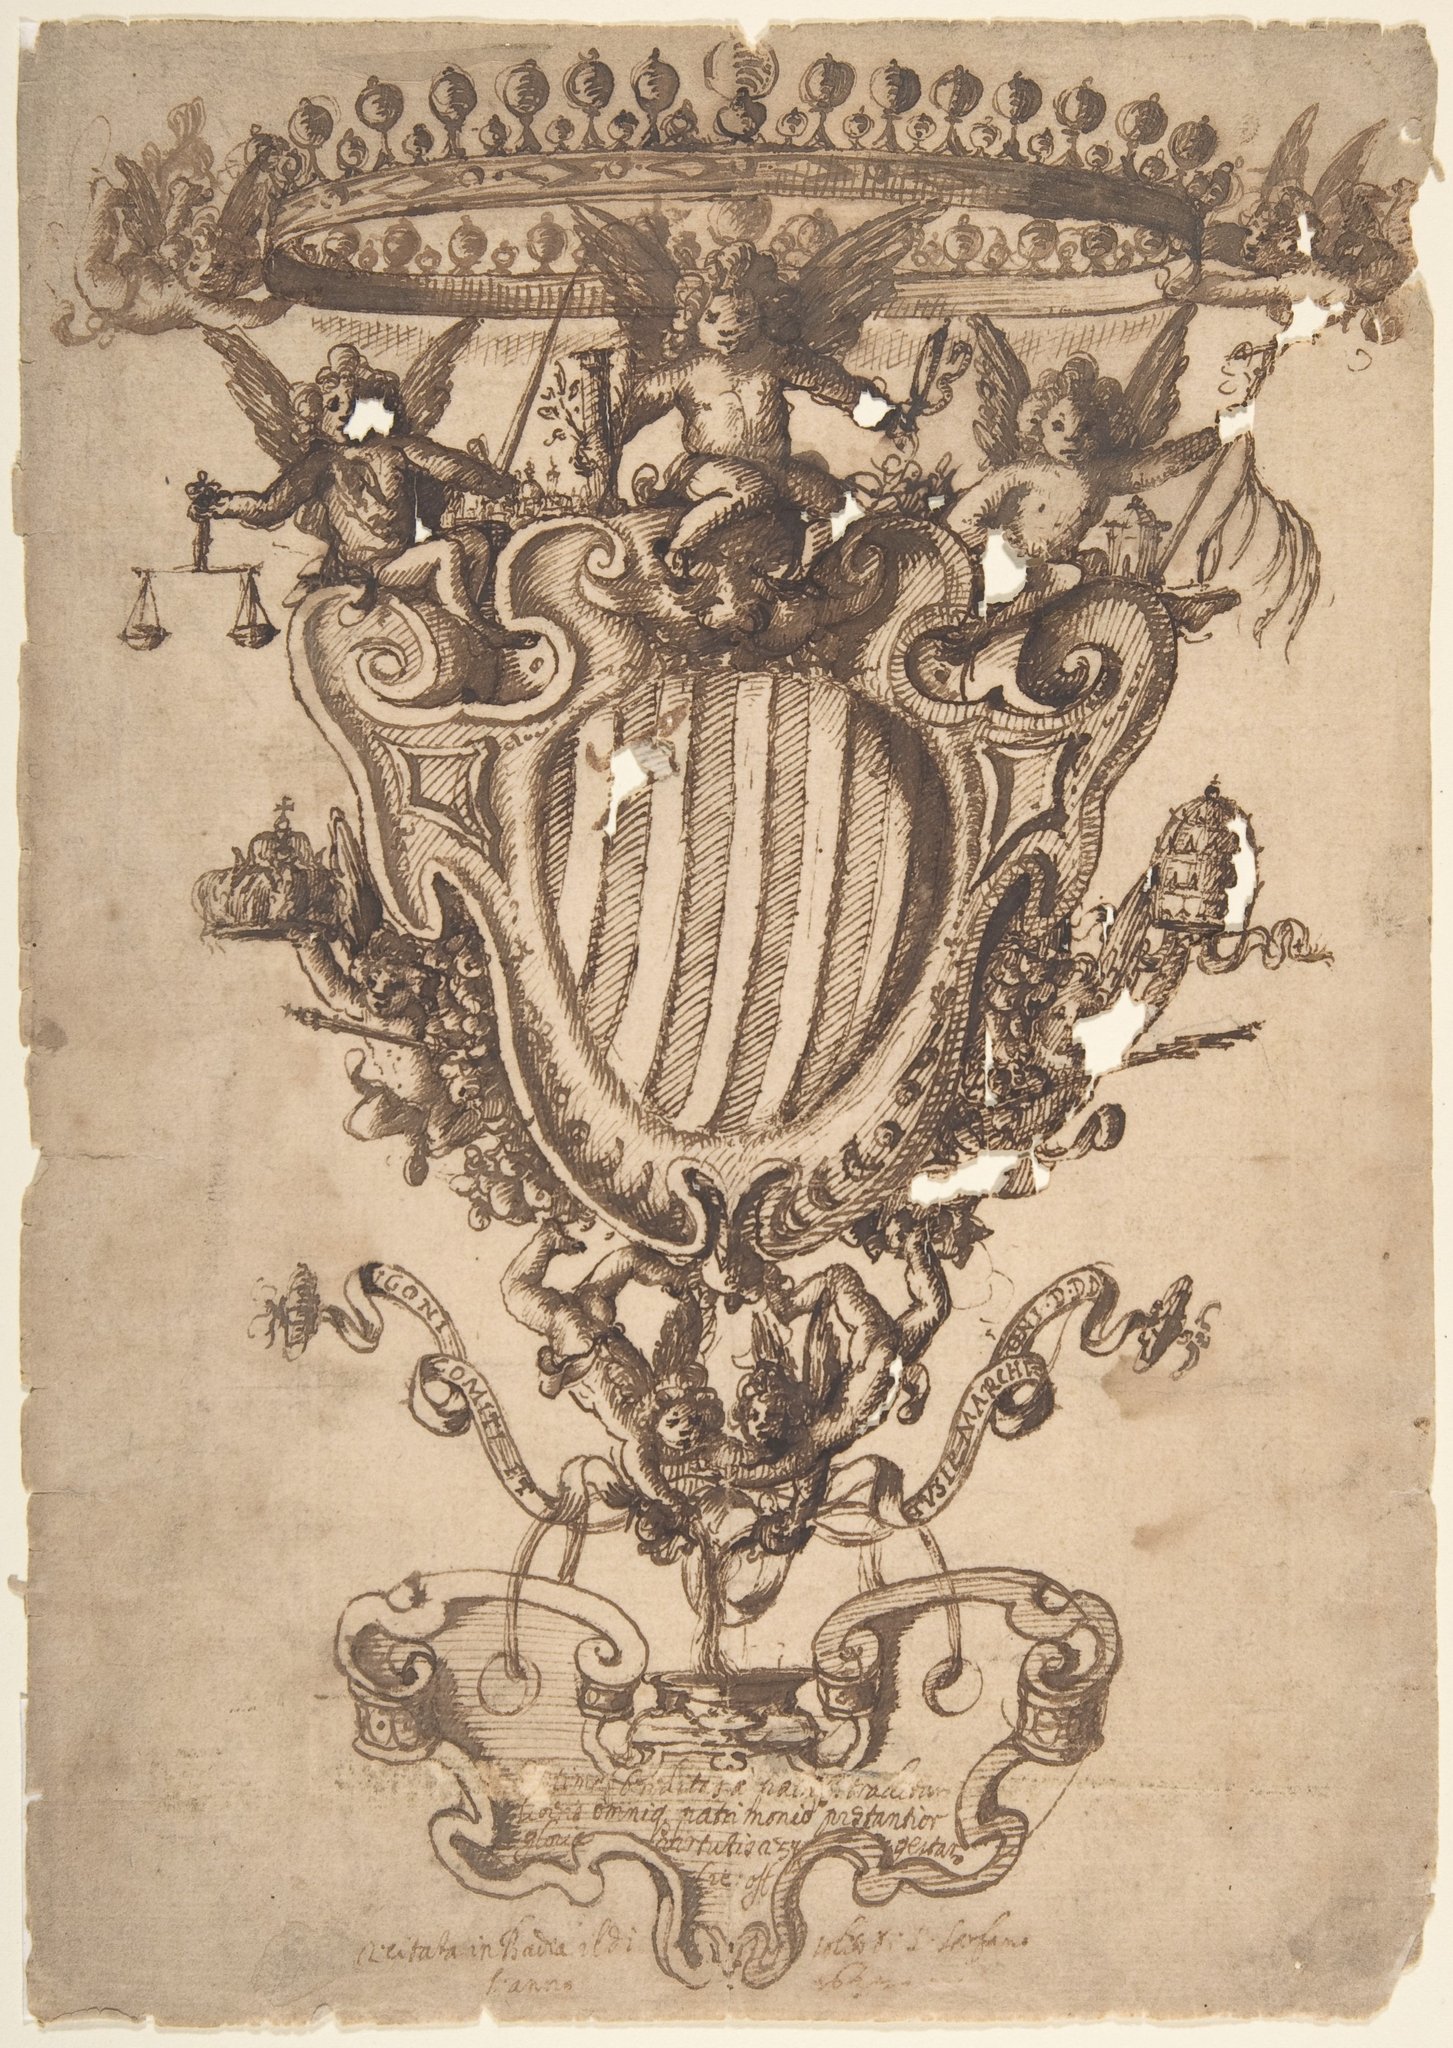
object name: drawing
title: Design for a Coat of Arms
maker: anonymous, italian, 17th century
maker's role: artist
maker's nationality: italian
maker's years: 1600-1700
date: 1601-1700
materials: ink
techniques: pen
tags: coat of arms